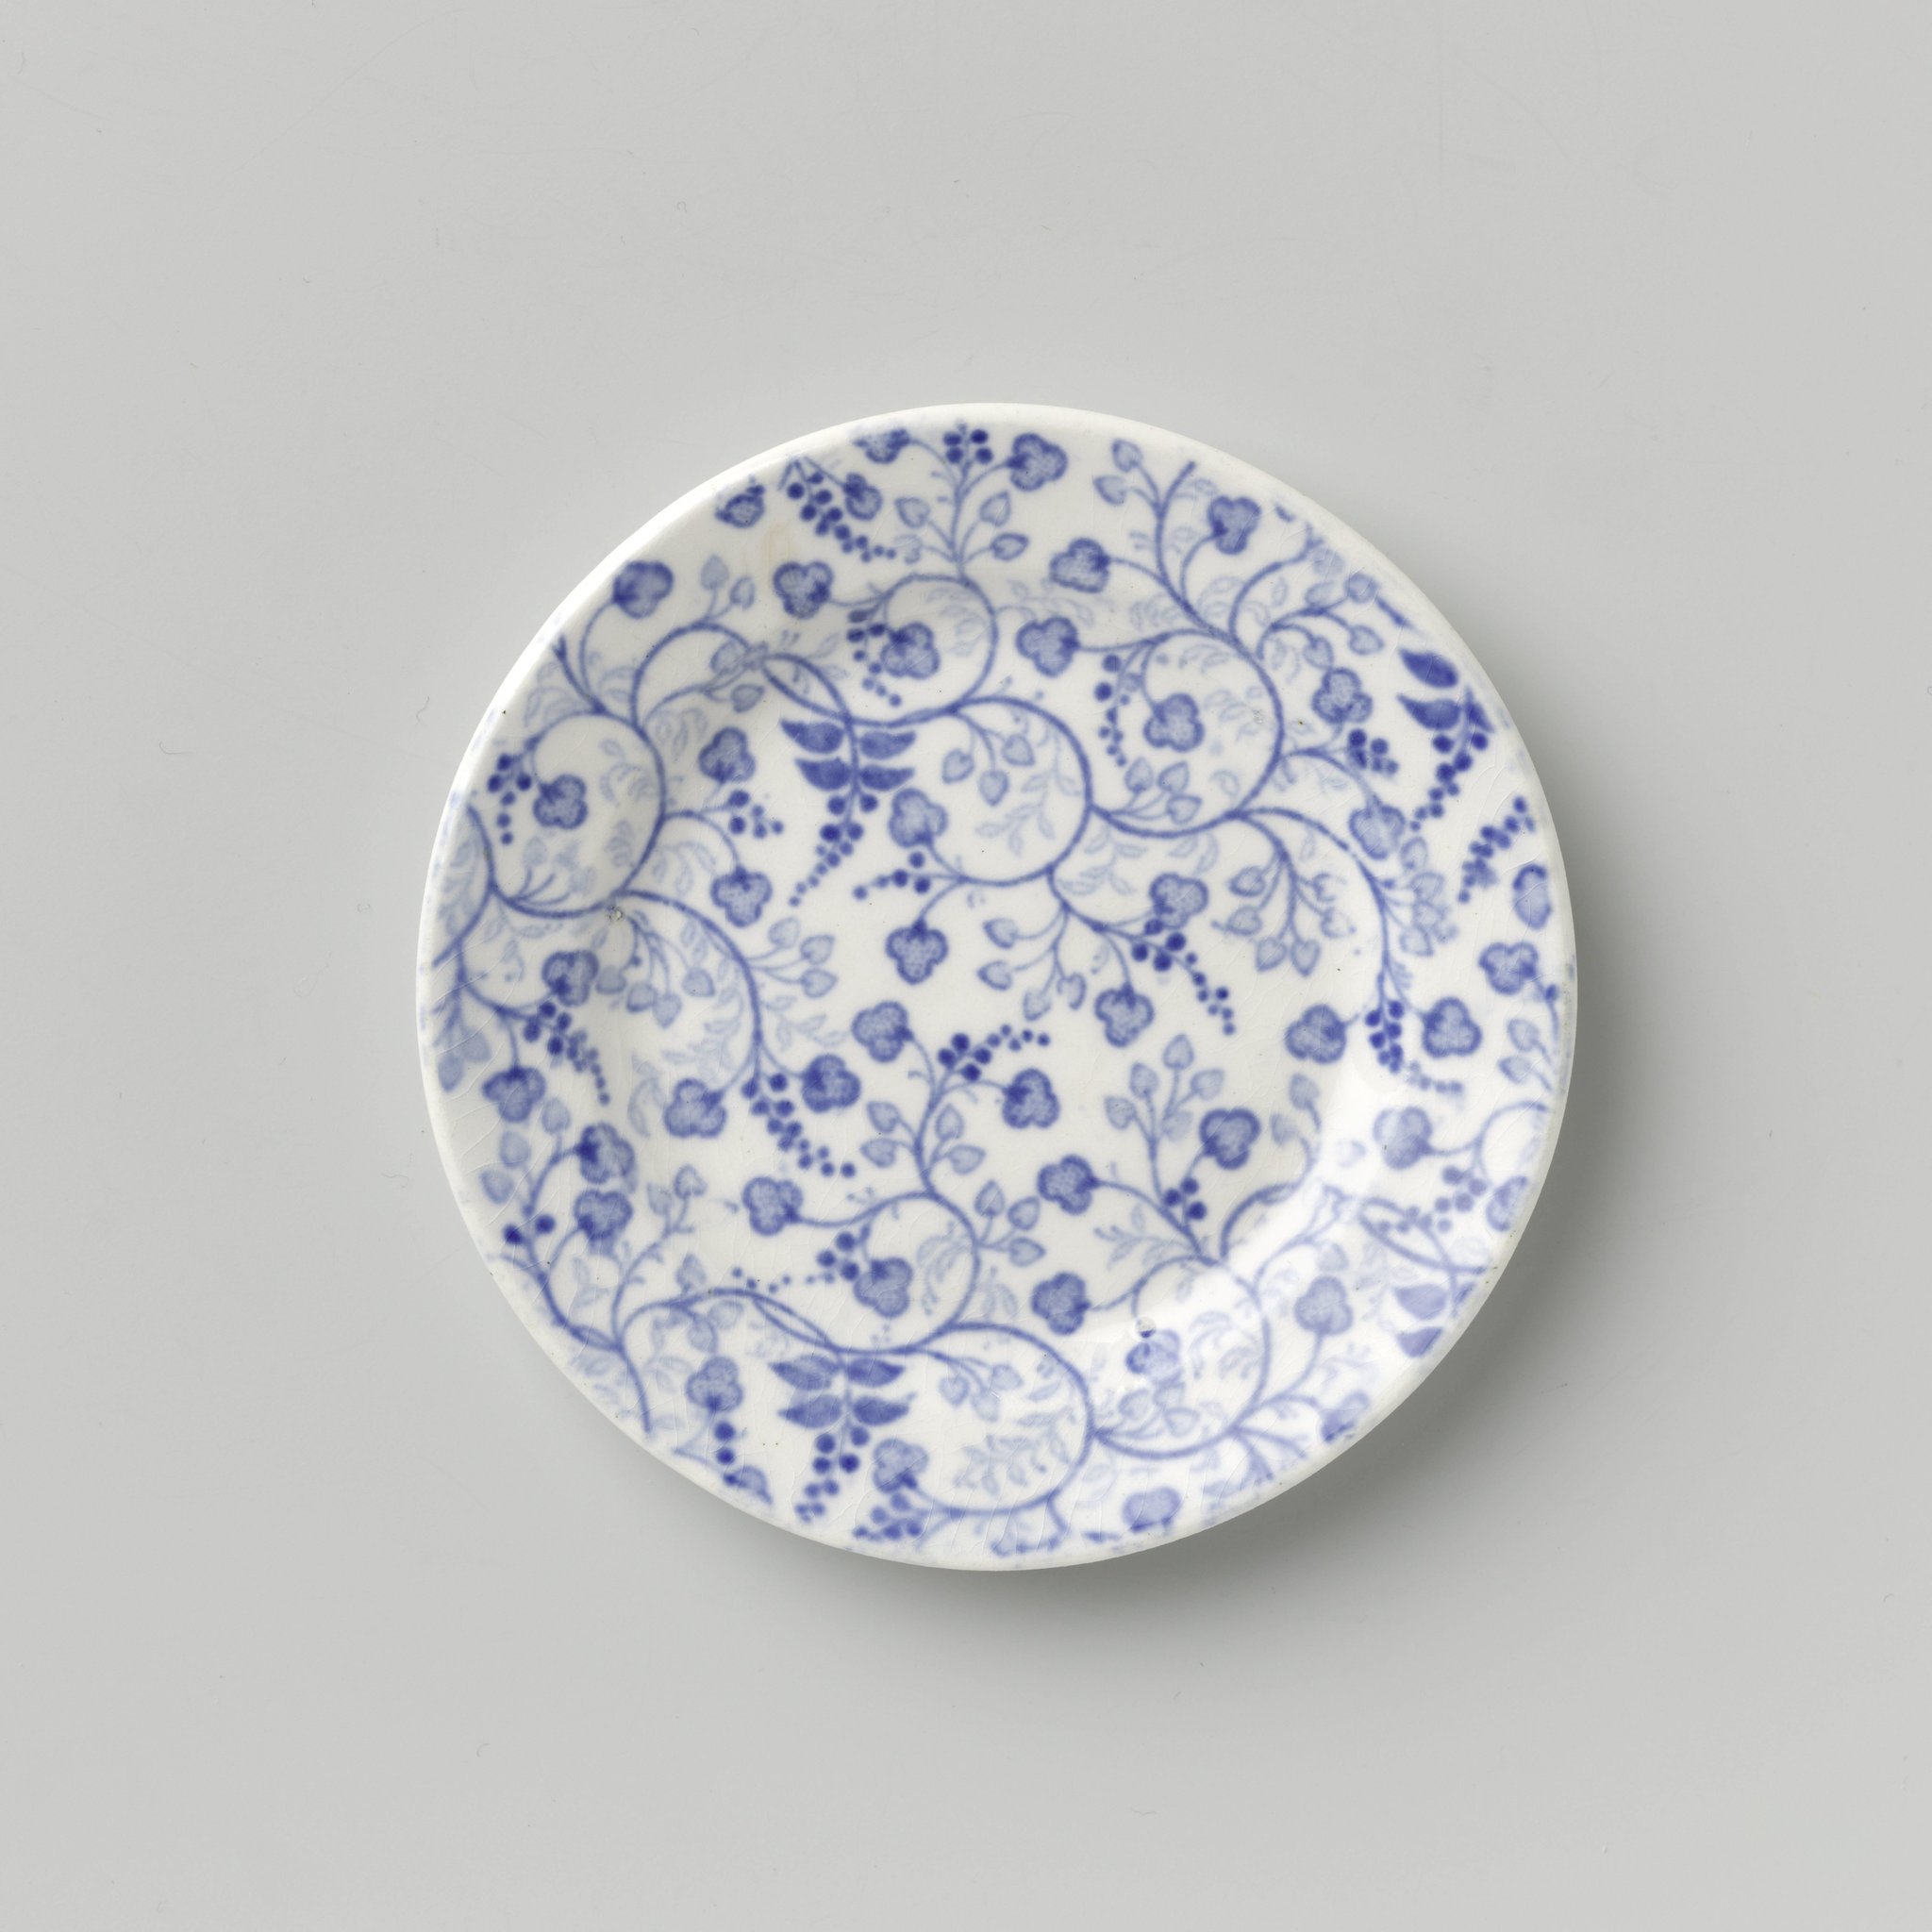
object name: plate dish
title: Bord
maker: petrus regout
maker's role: plateelbakker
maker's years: 1801-1879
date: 1867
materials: creamware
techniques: transfer decoration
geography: maastricht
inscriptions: check stamp: ‘PR’, mark: ‘PARSEME No 3 9’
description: Bord van aardewerk, met blauw doorlopend bloemendecor, behorend tot een kinderservies.